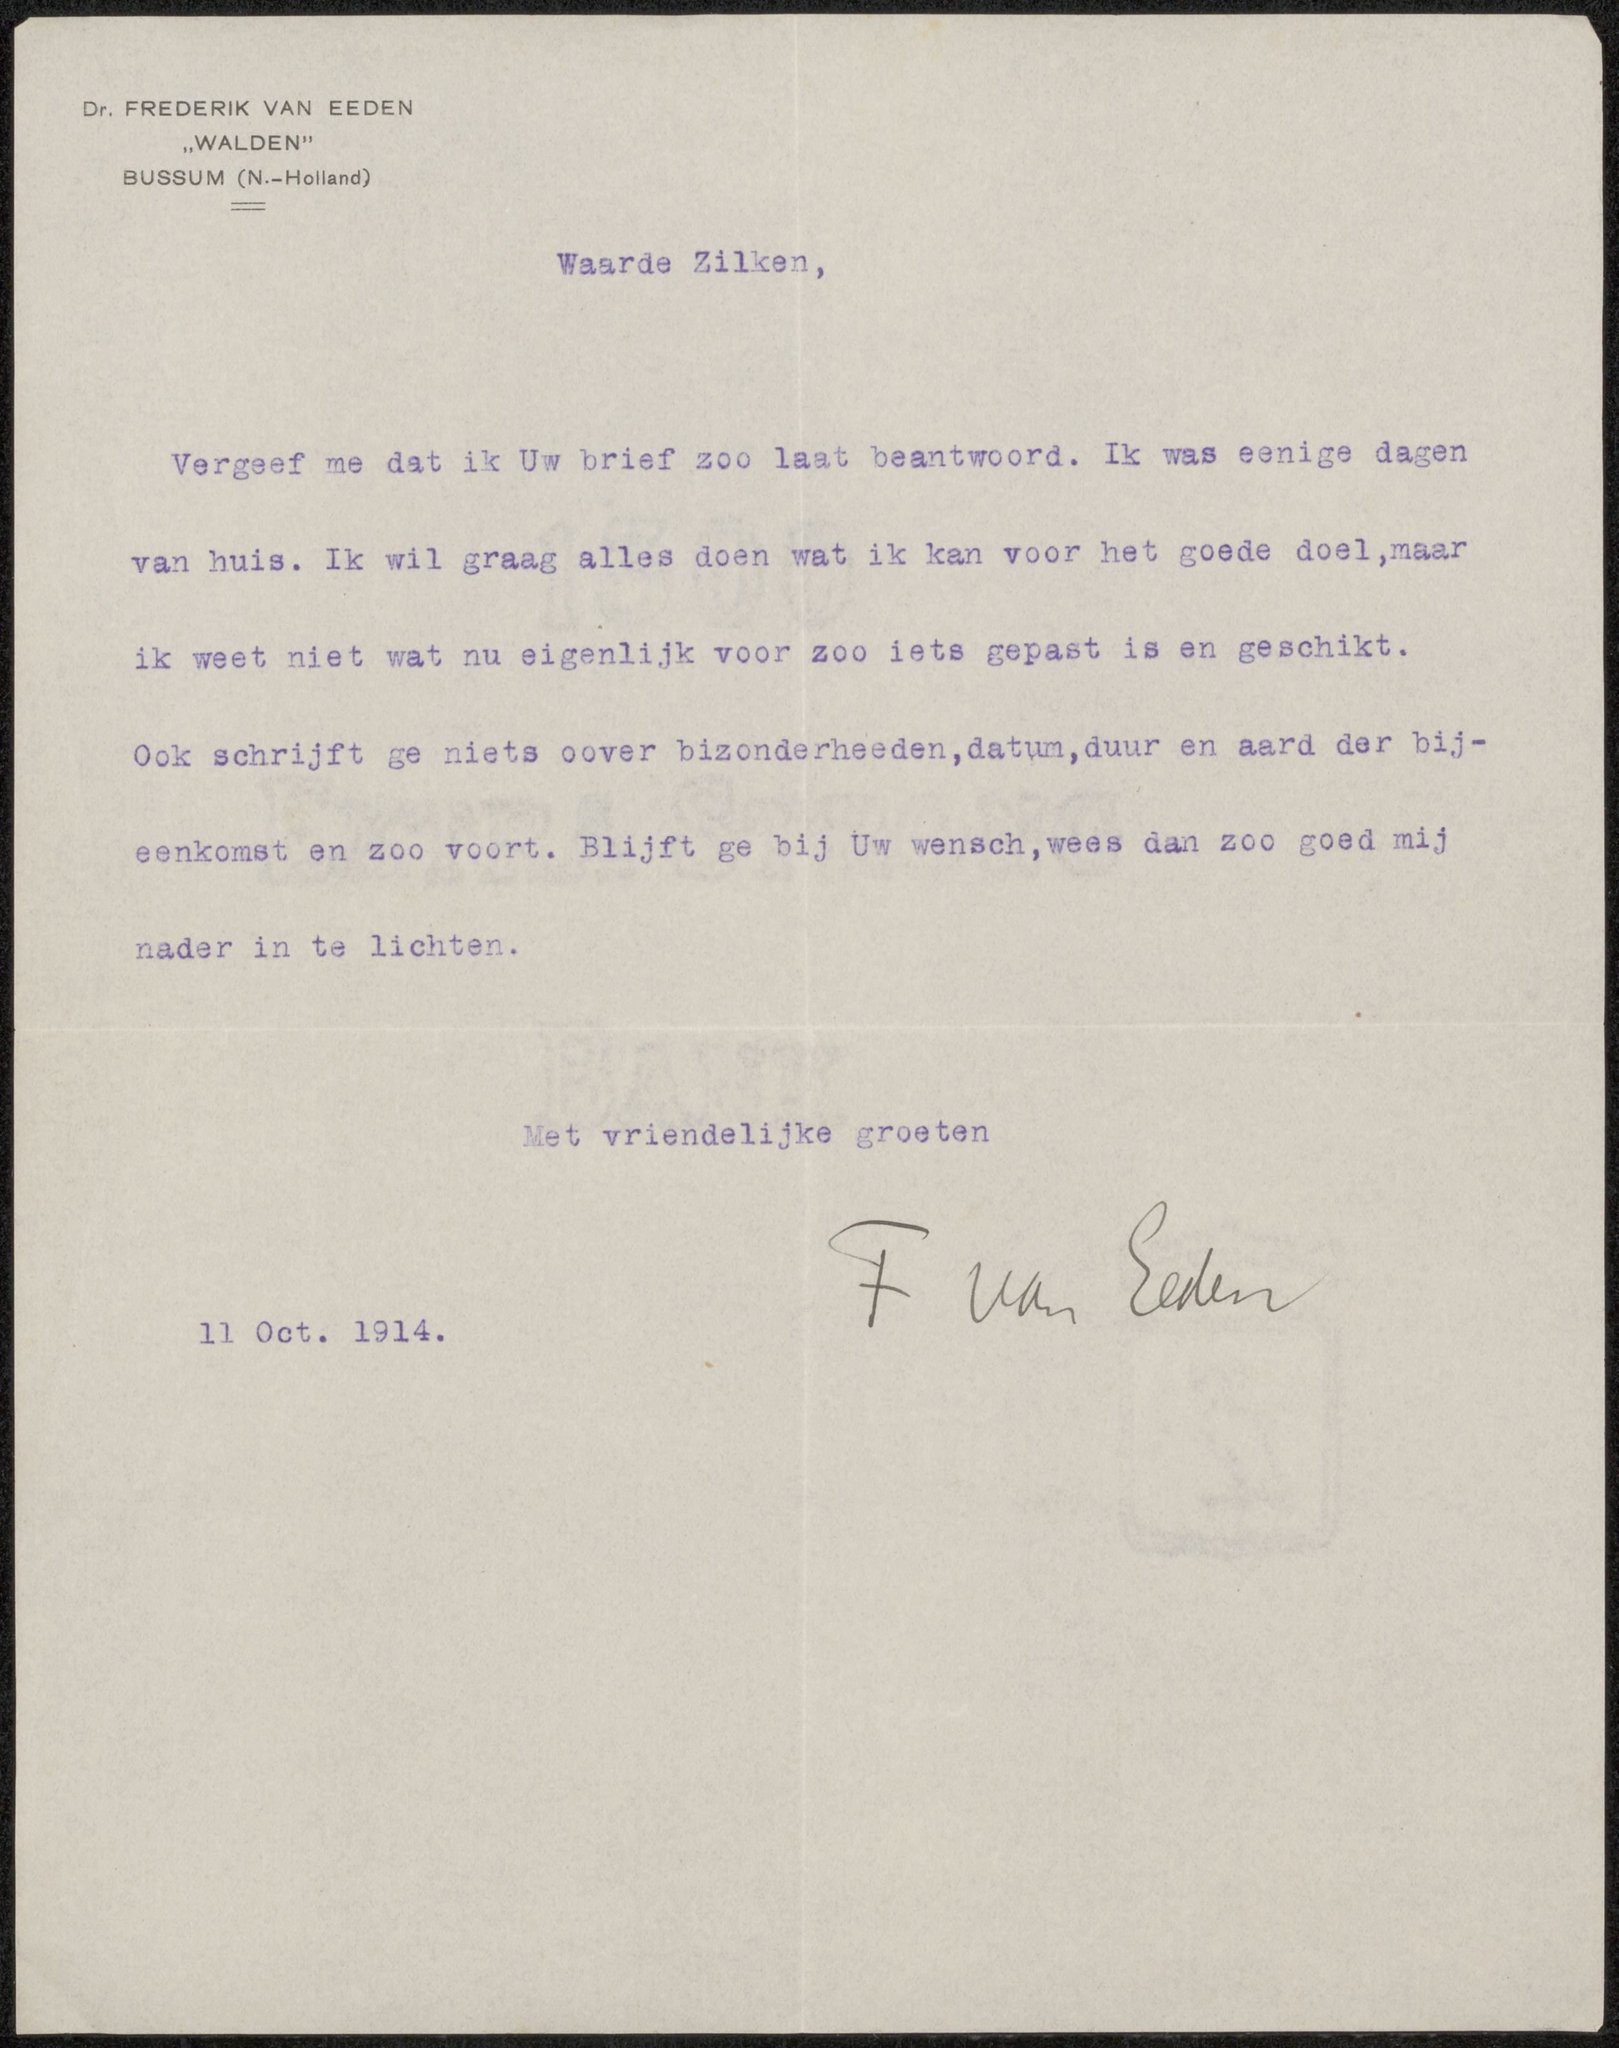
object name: letter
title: Brief aan Philip Zilcken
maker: frederik van eeden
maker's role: schrijver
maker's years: 1860-1932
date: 1914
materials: ink, paper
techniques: pen, printing, typewriting, writing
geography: bussum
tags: painter, draughtsman, philip zilcken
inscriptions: collector's mark: ‘RPK’